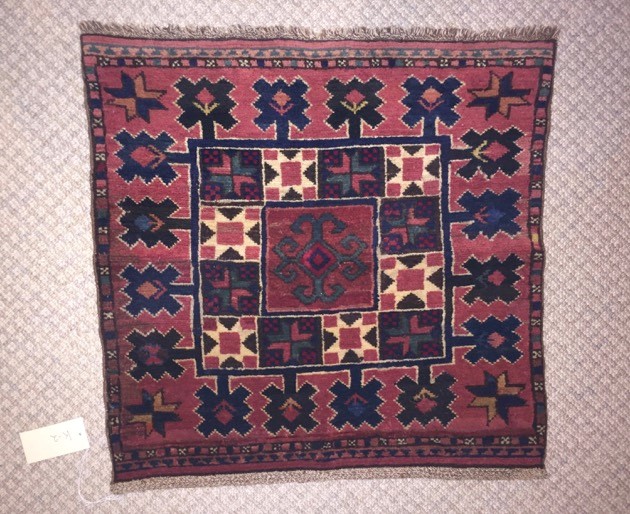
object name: saddle bag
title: Kirghiz Bag Face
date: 1867-1900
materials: cotton, wool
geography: kyrgyzstan